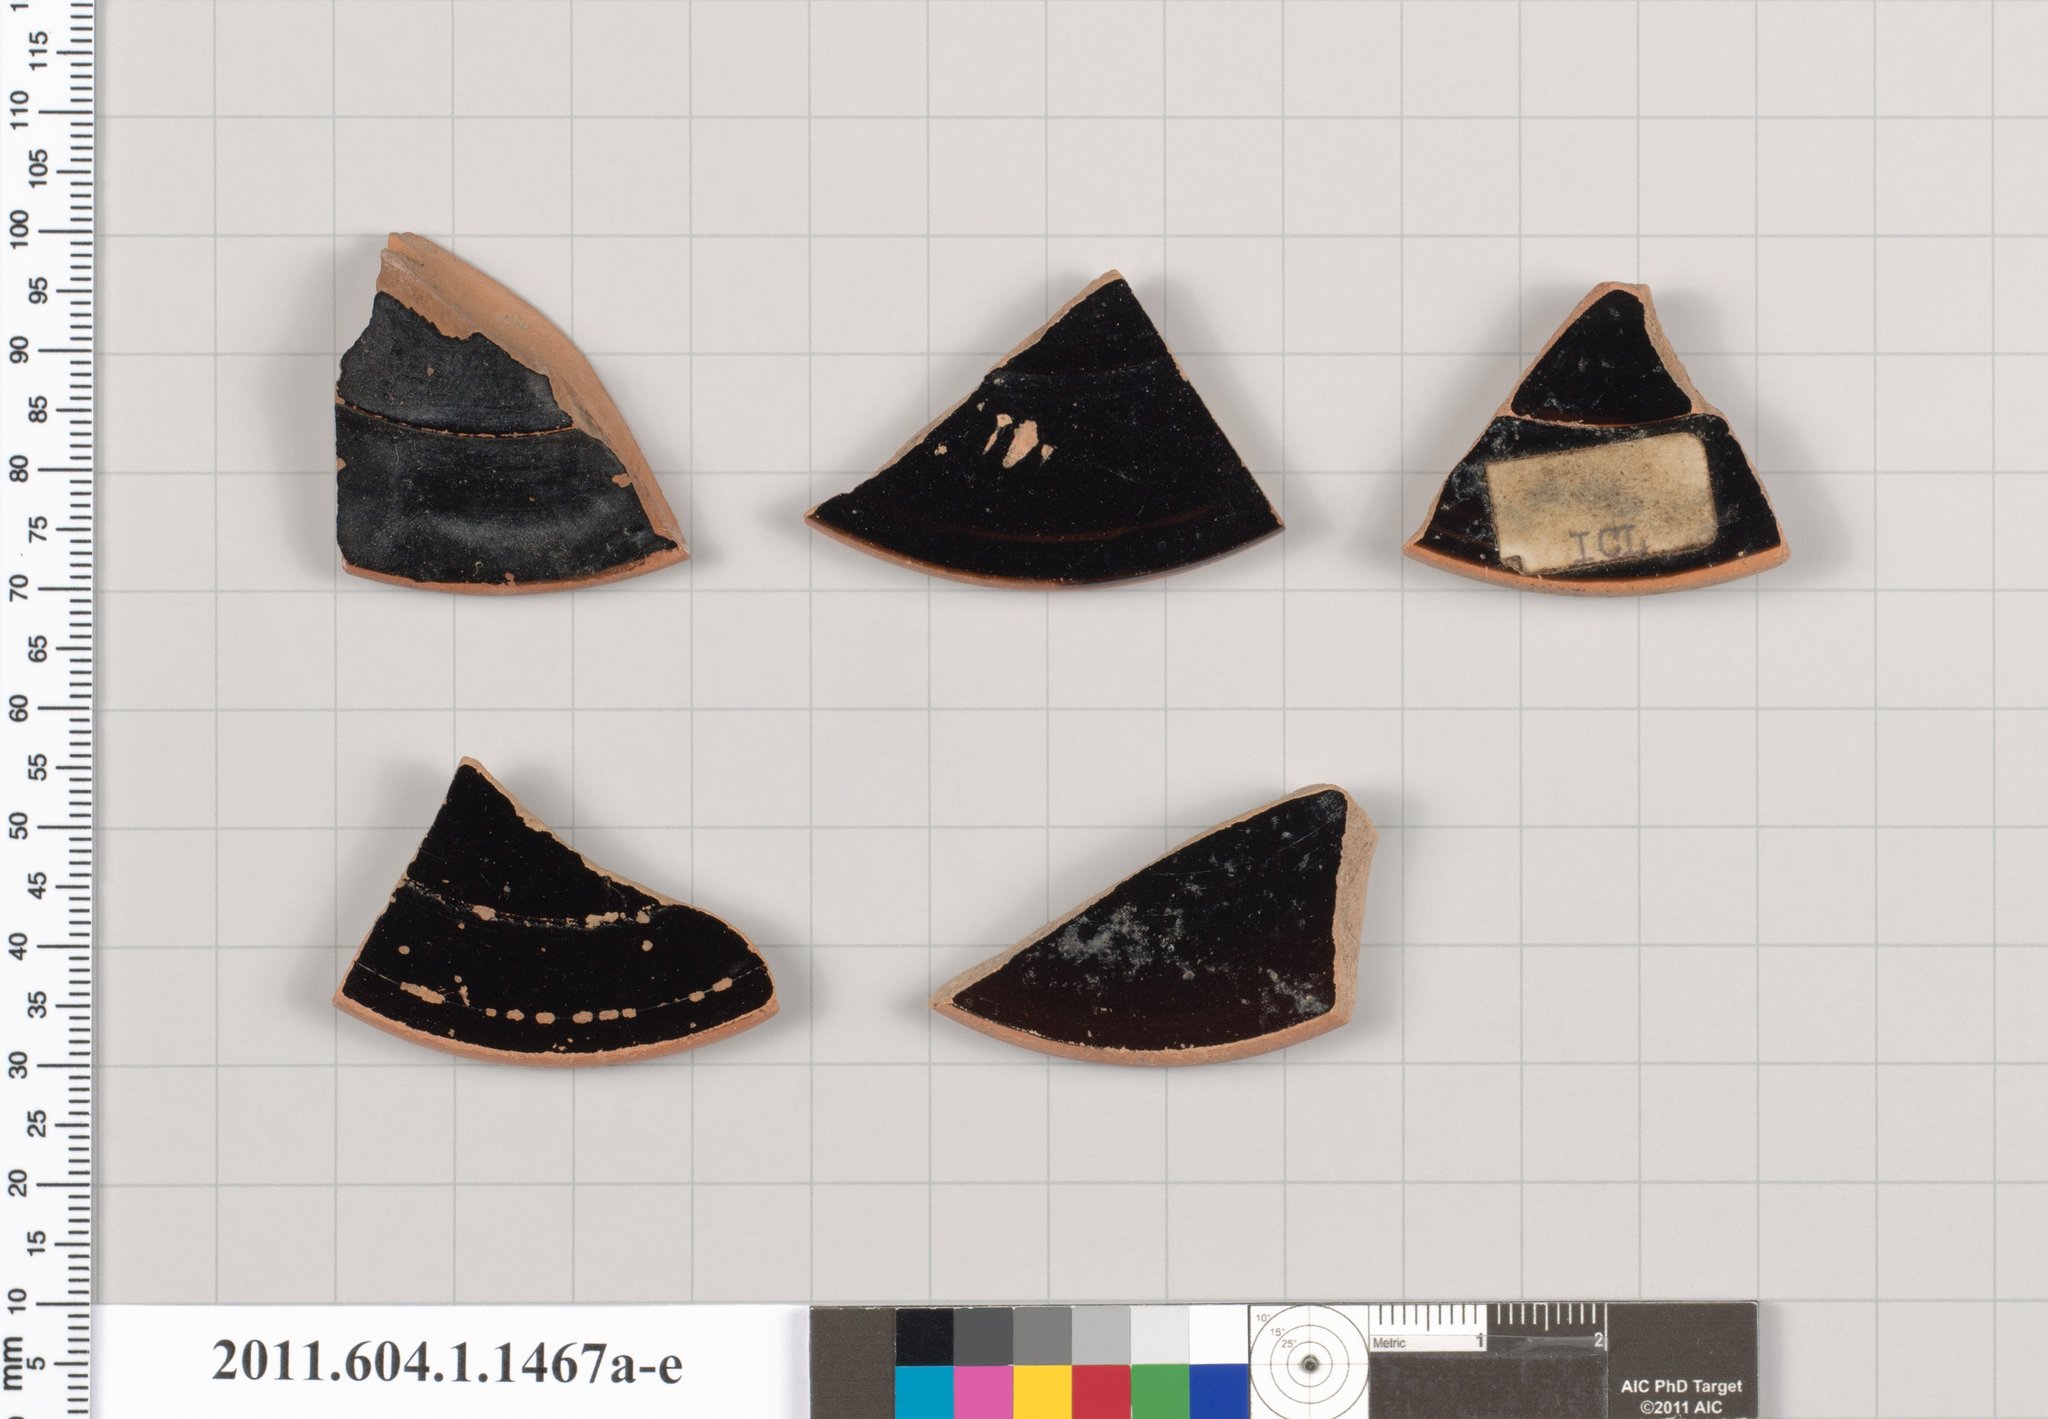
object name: kylix fragment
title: Terracotta fragments of kylikes (drinking cups)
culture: greek, attic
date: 500-401 BCE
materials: terracotta